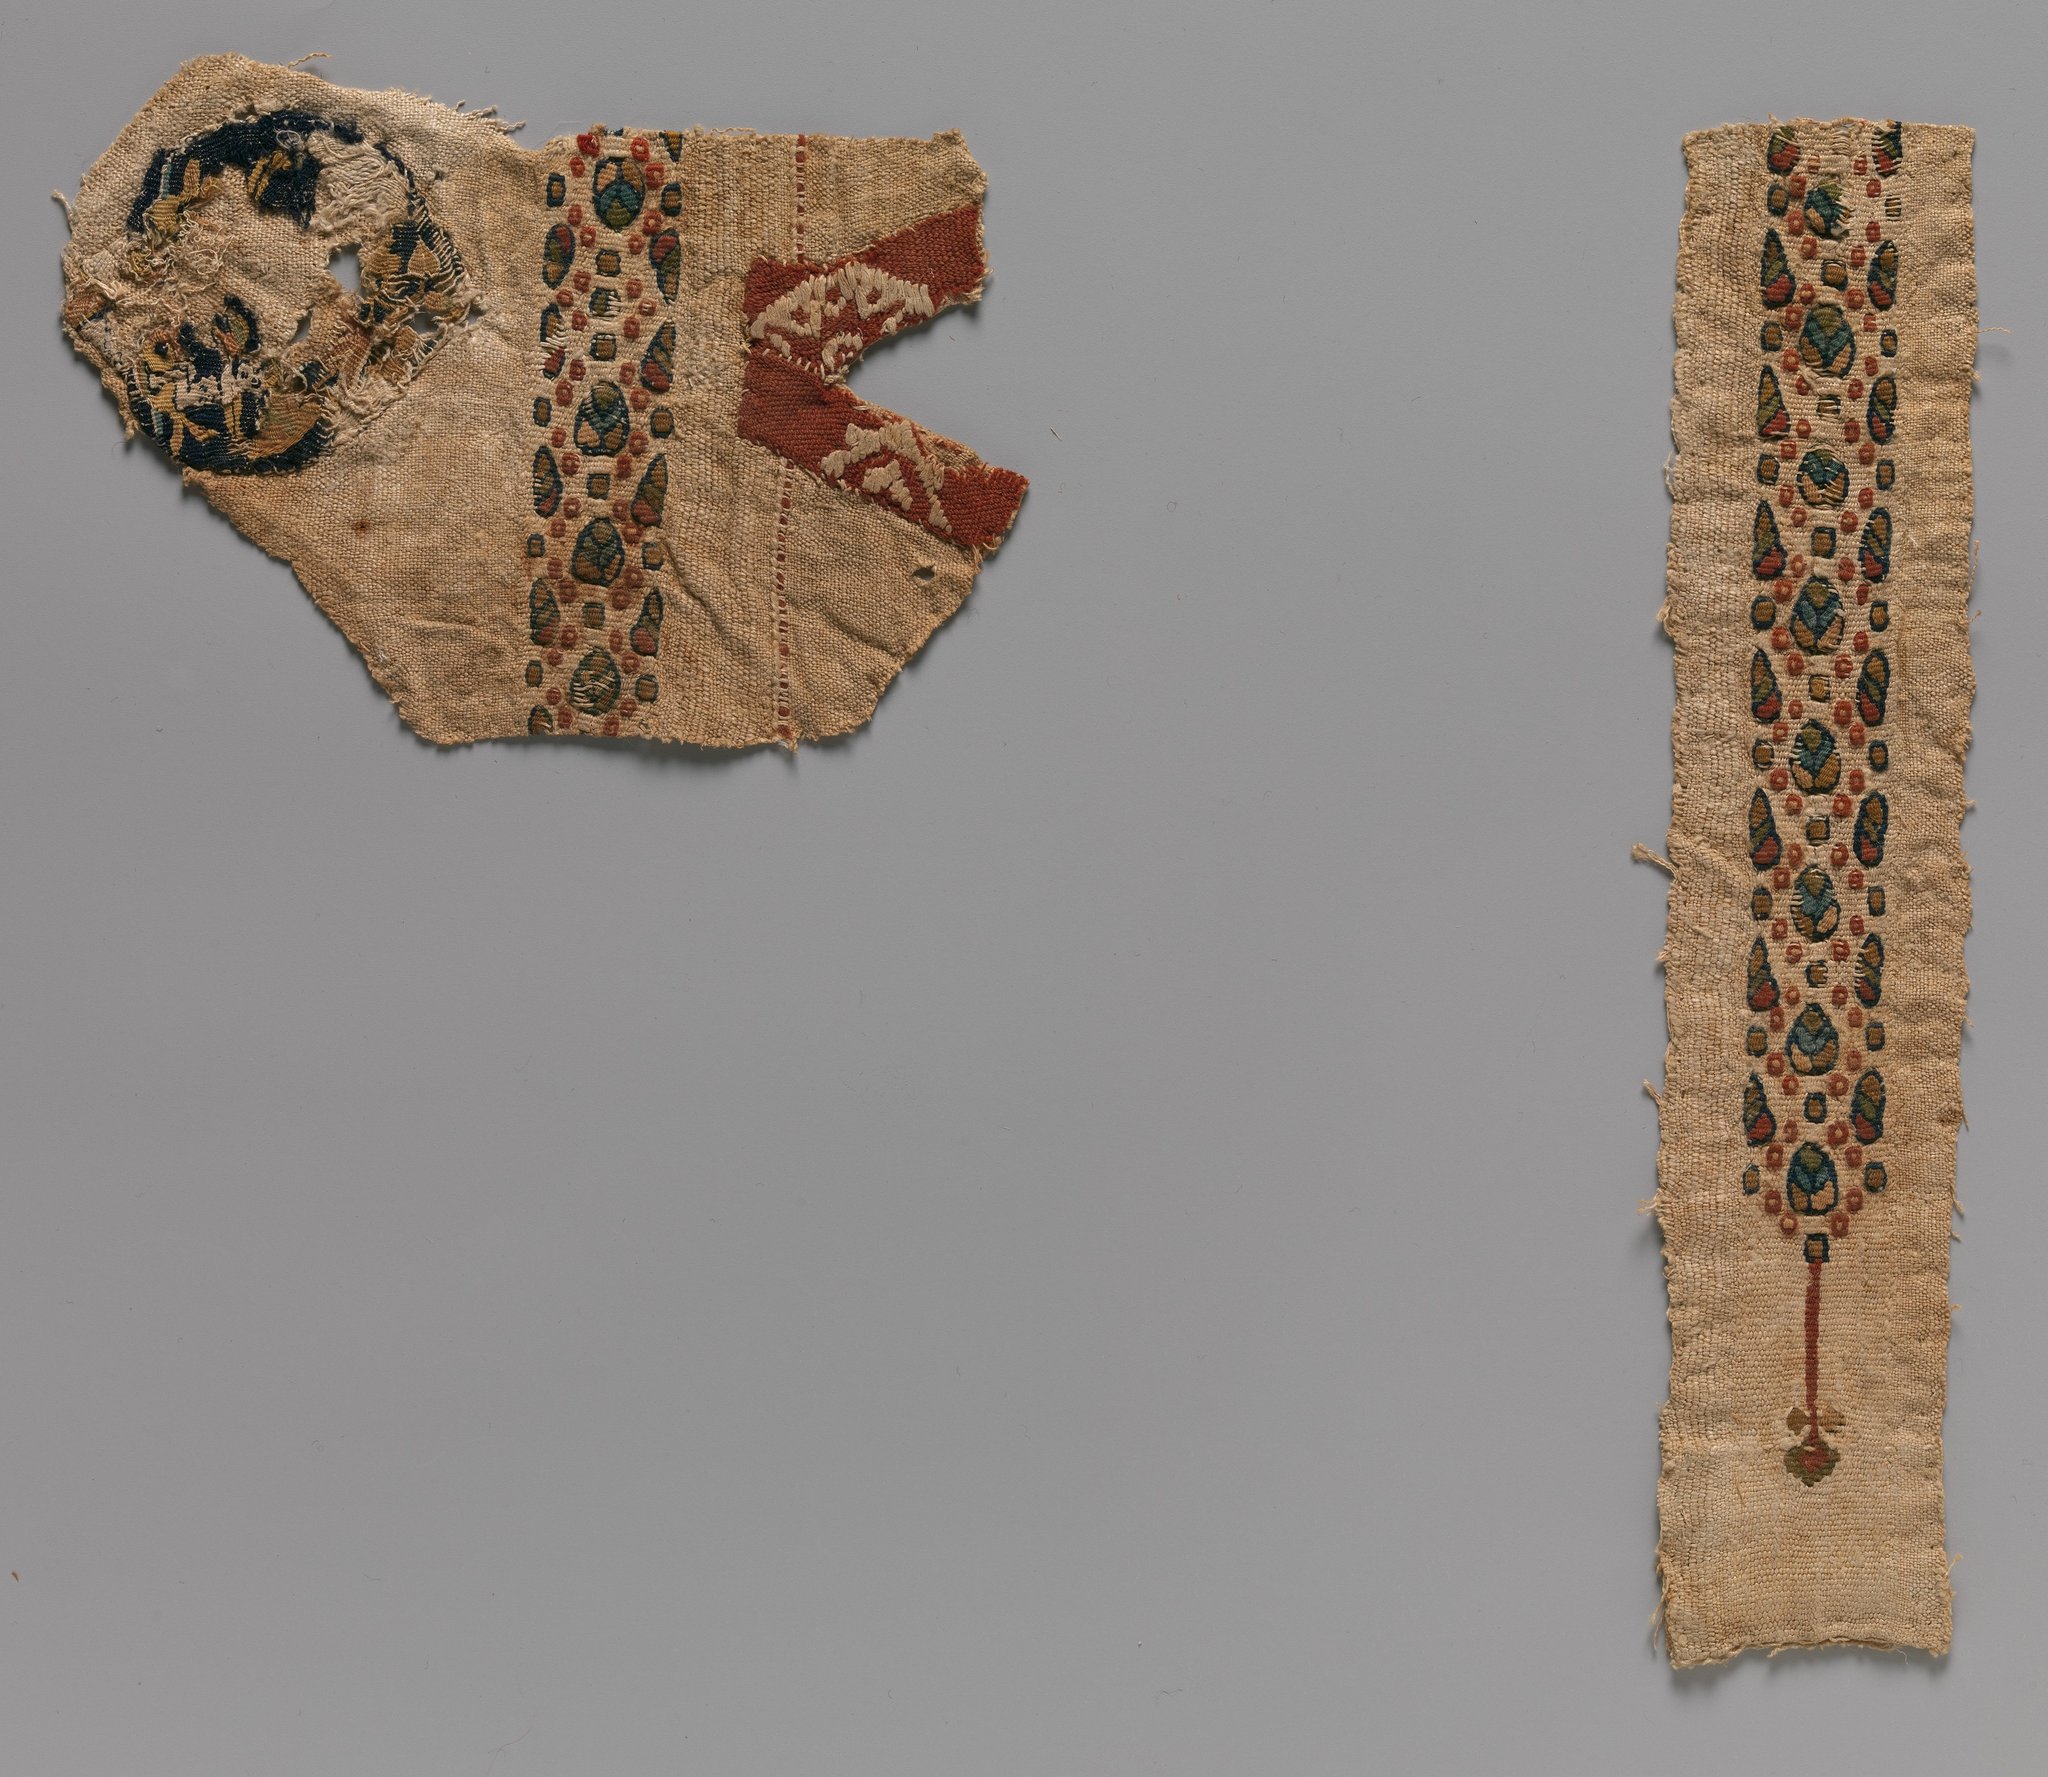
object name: tunic fragment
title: Tunic Fragments with Scattered Design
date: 501-800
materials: linen, wool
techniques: weave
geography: egypt